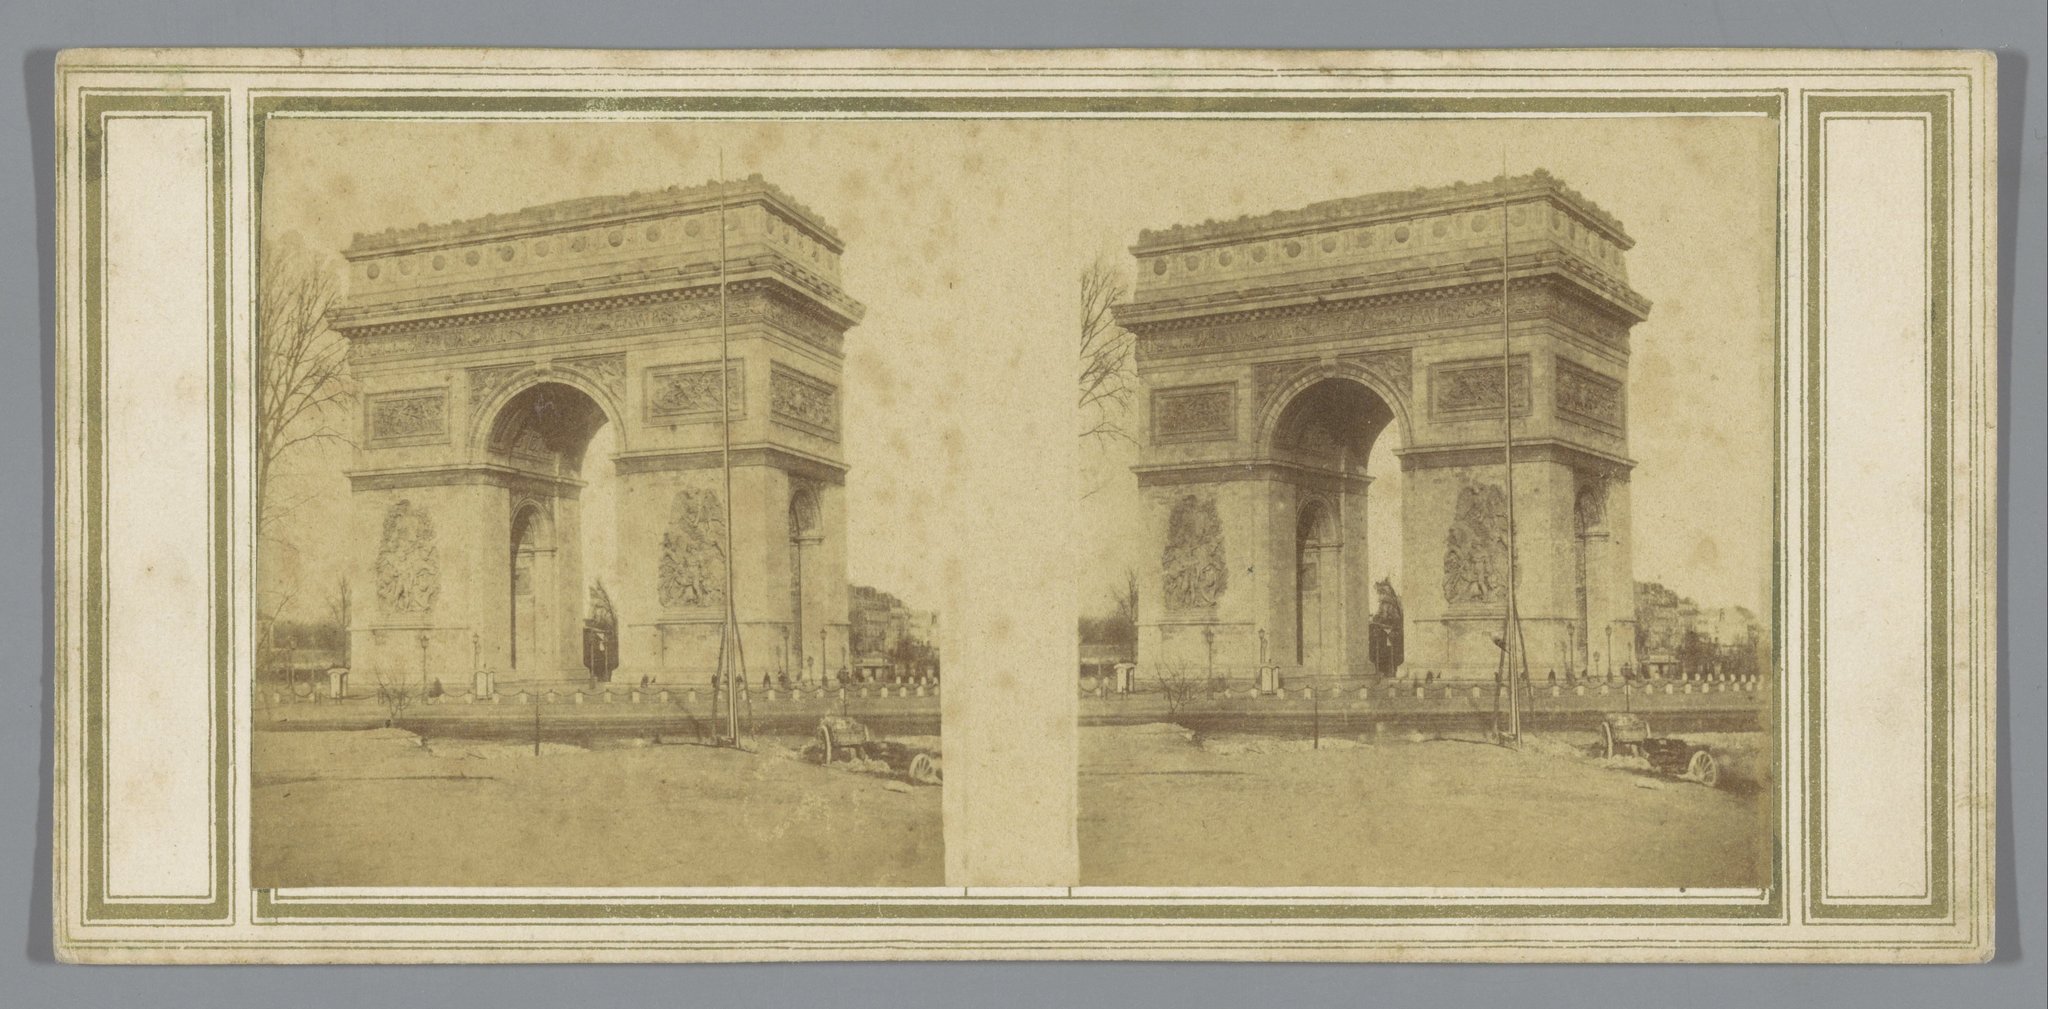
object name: stereograph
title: Arc de Triomphe, Parijs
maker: Anonymous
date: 1857-1863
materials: cardboard, paper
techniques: albumen print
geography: paris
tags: triumphal arch